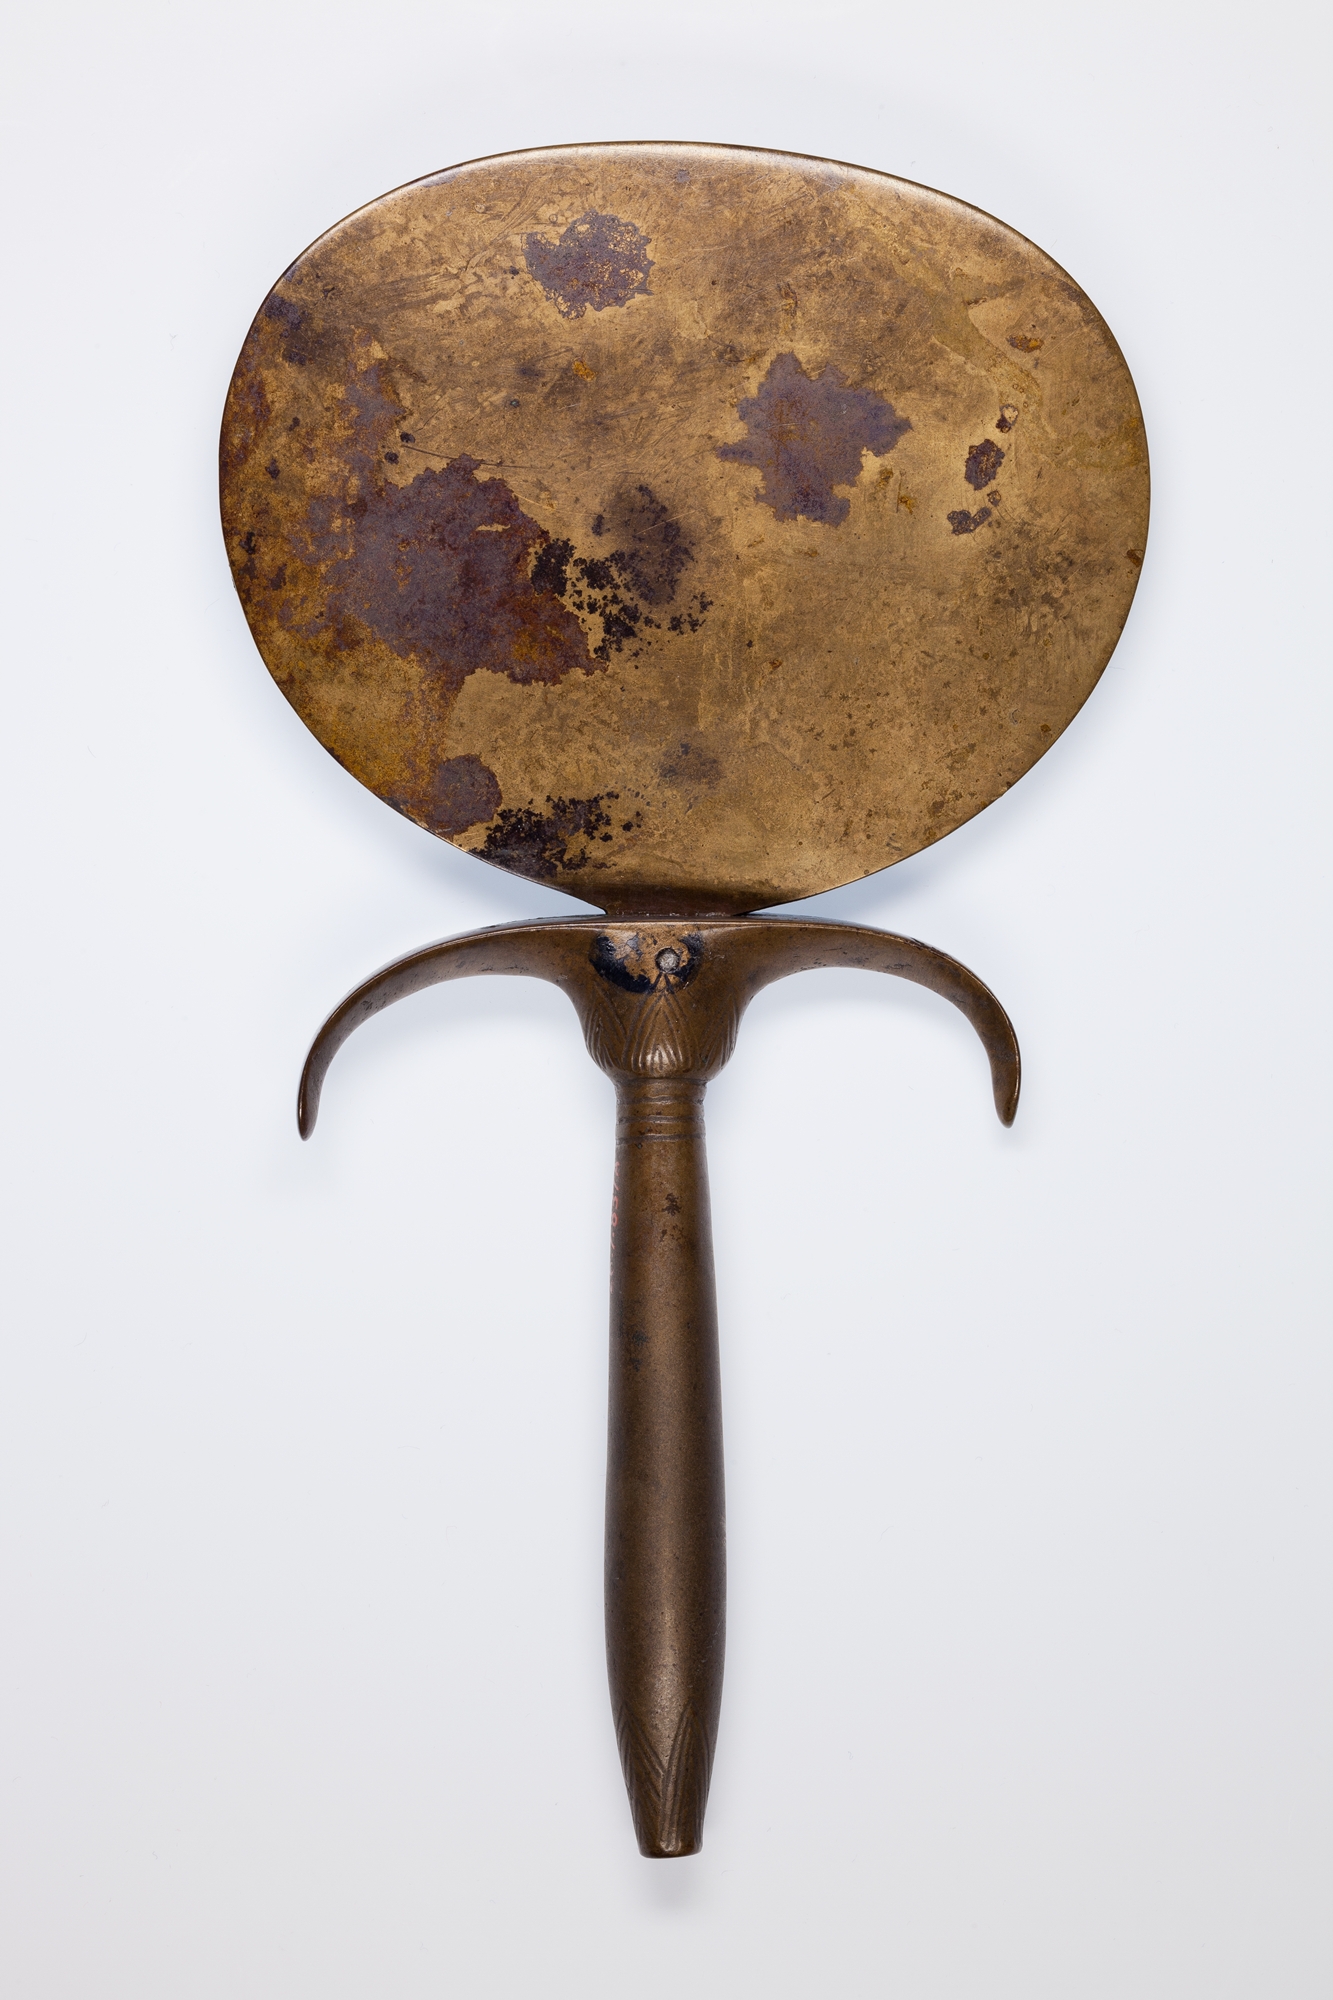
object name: mirror handle, papyrus umbel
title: Mirror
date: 1550-1458 BCE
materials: bronze, copper alloy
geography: egypt